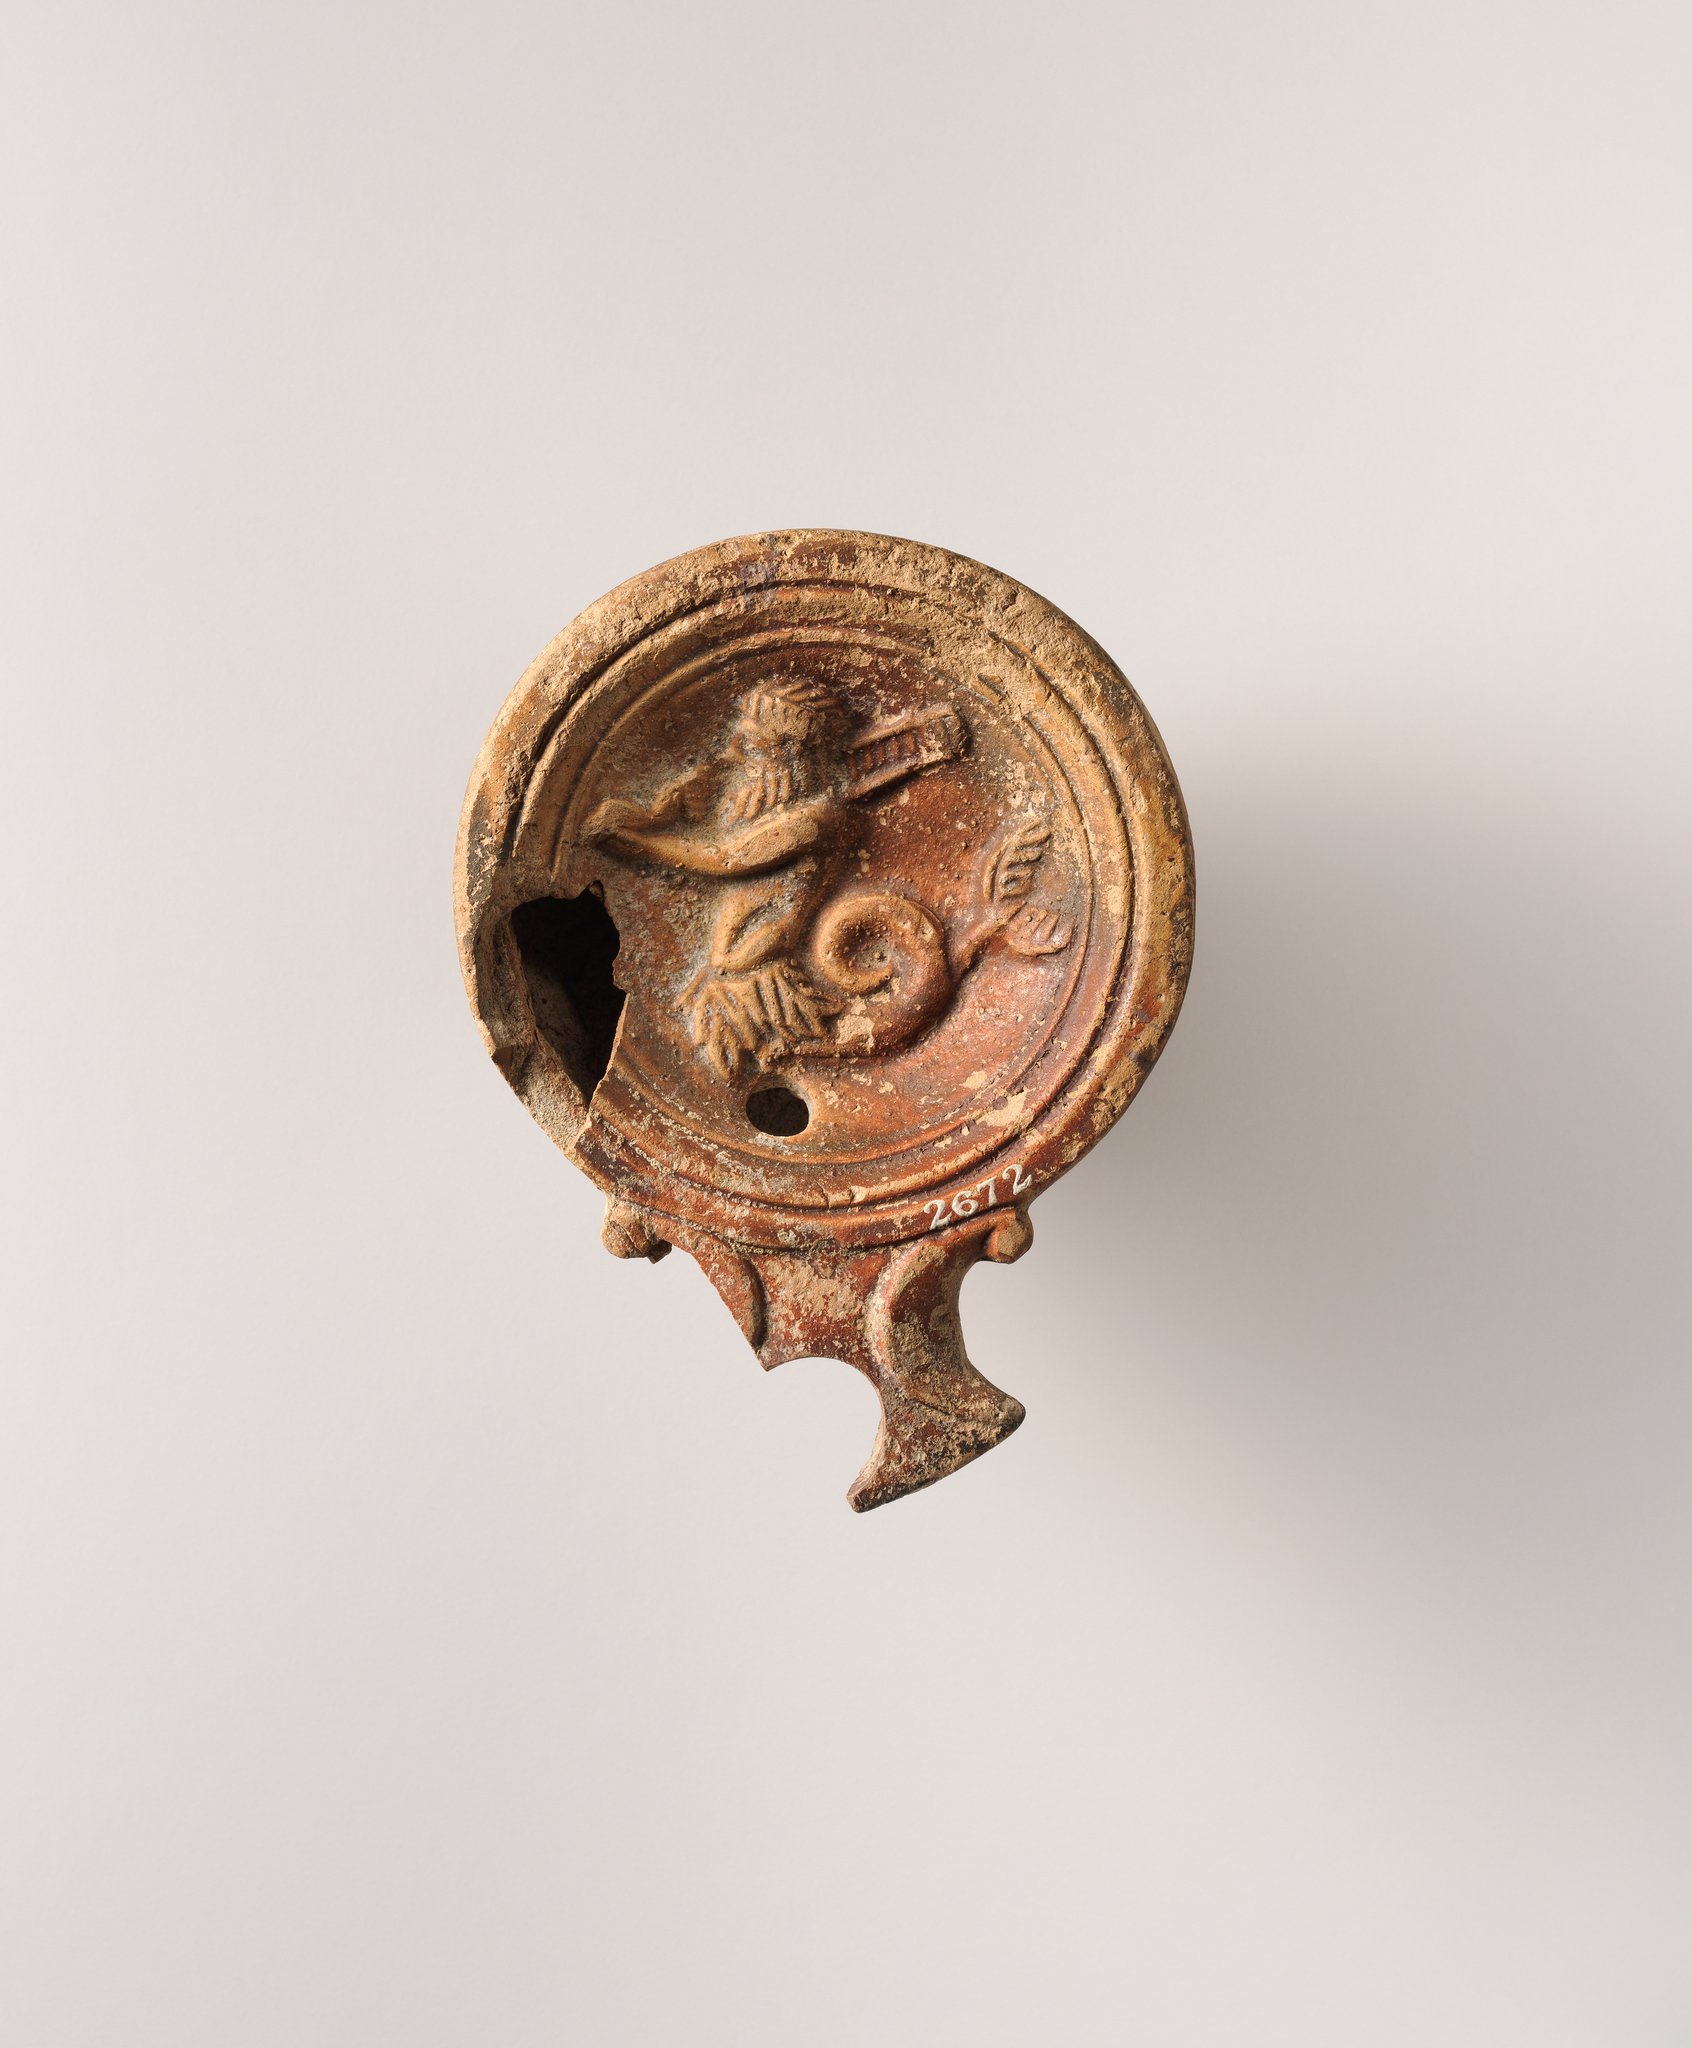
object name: lamp, concave top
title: Terracotta oil lamp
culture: roman, cypriot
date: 100 BCE-100 CE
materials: terracotta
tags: triton